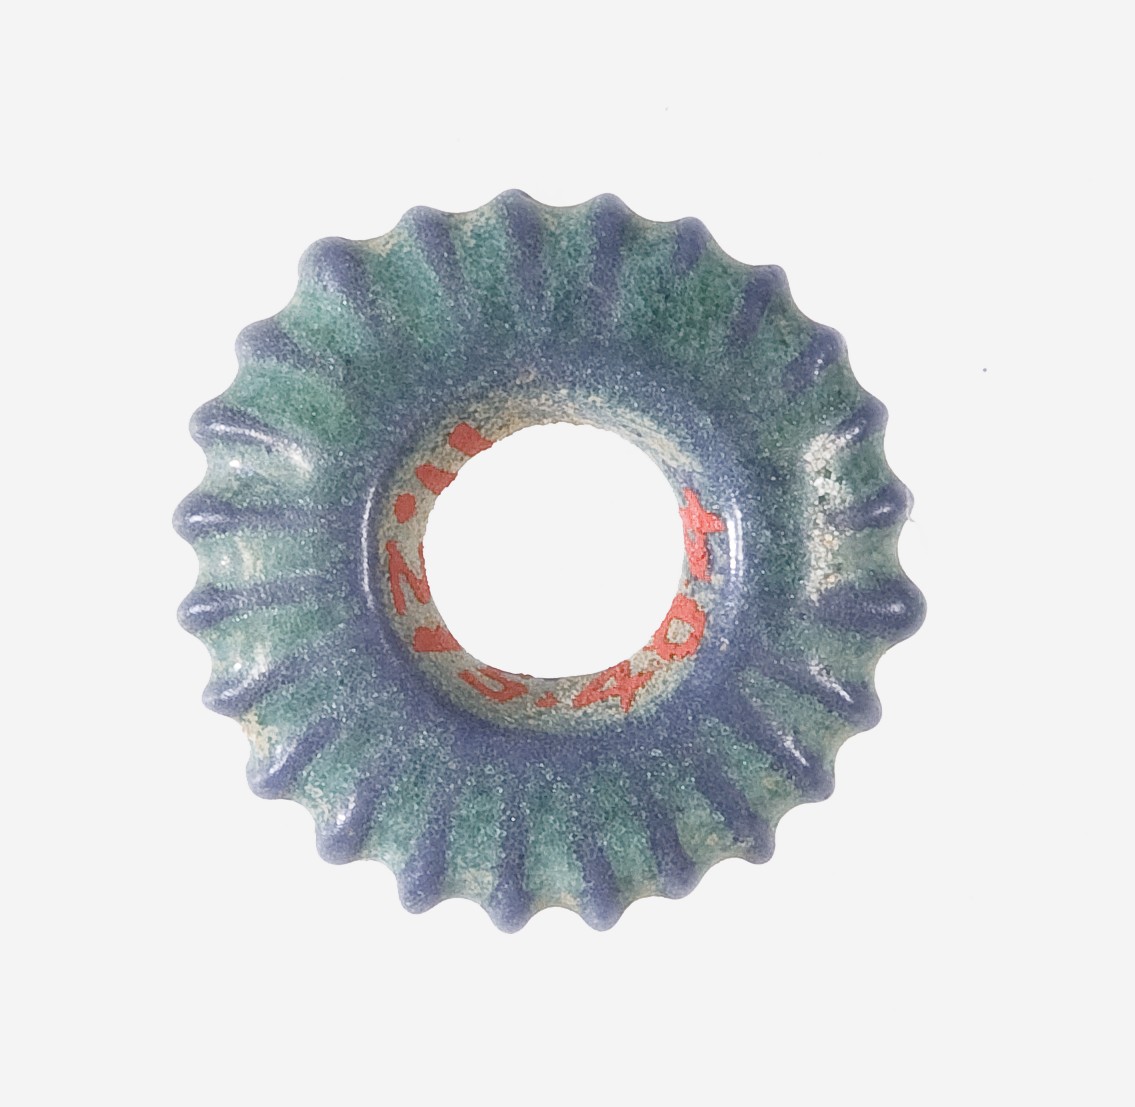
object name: pendant, ring shaped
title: Ring Pendant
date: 1390-1352 BCE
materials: faience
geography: egypt